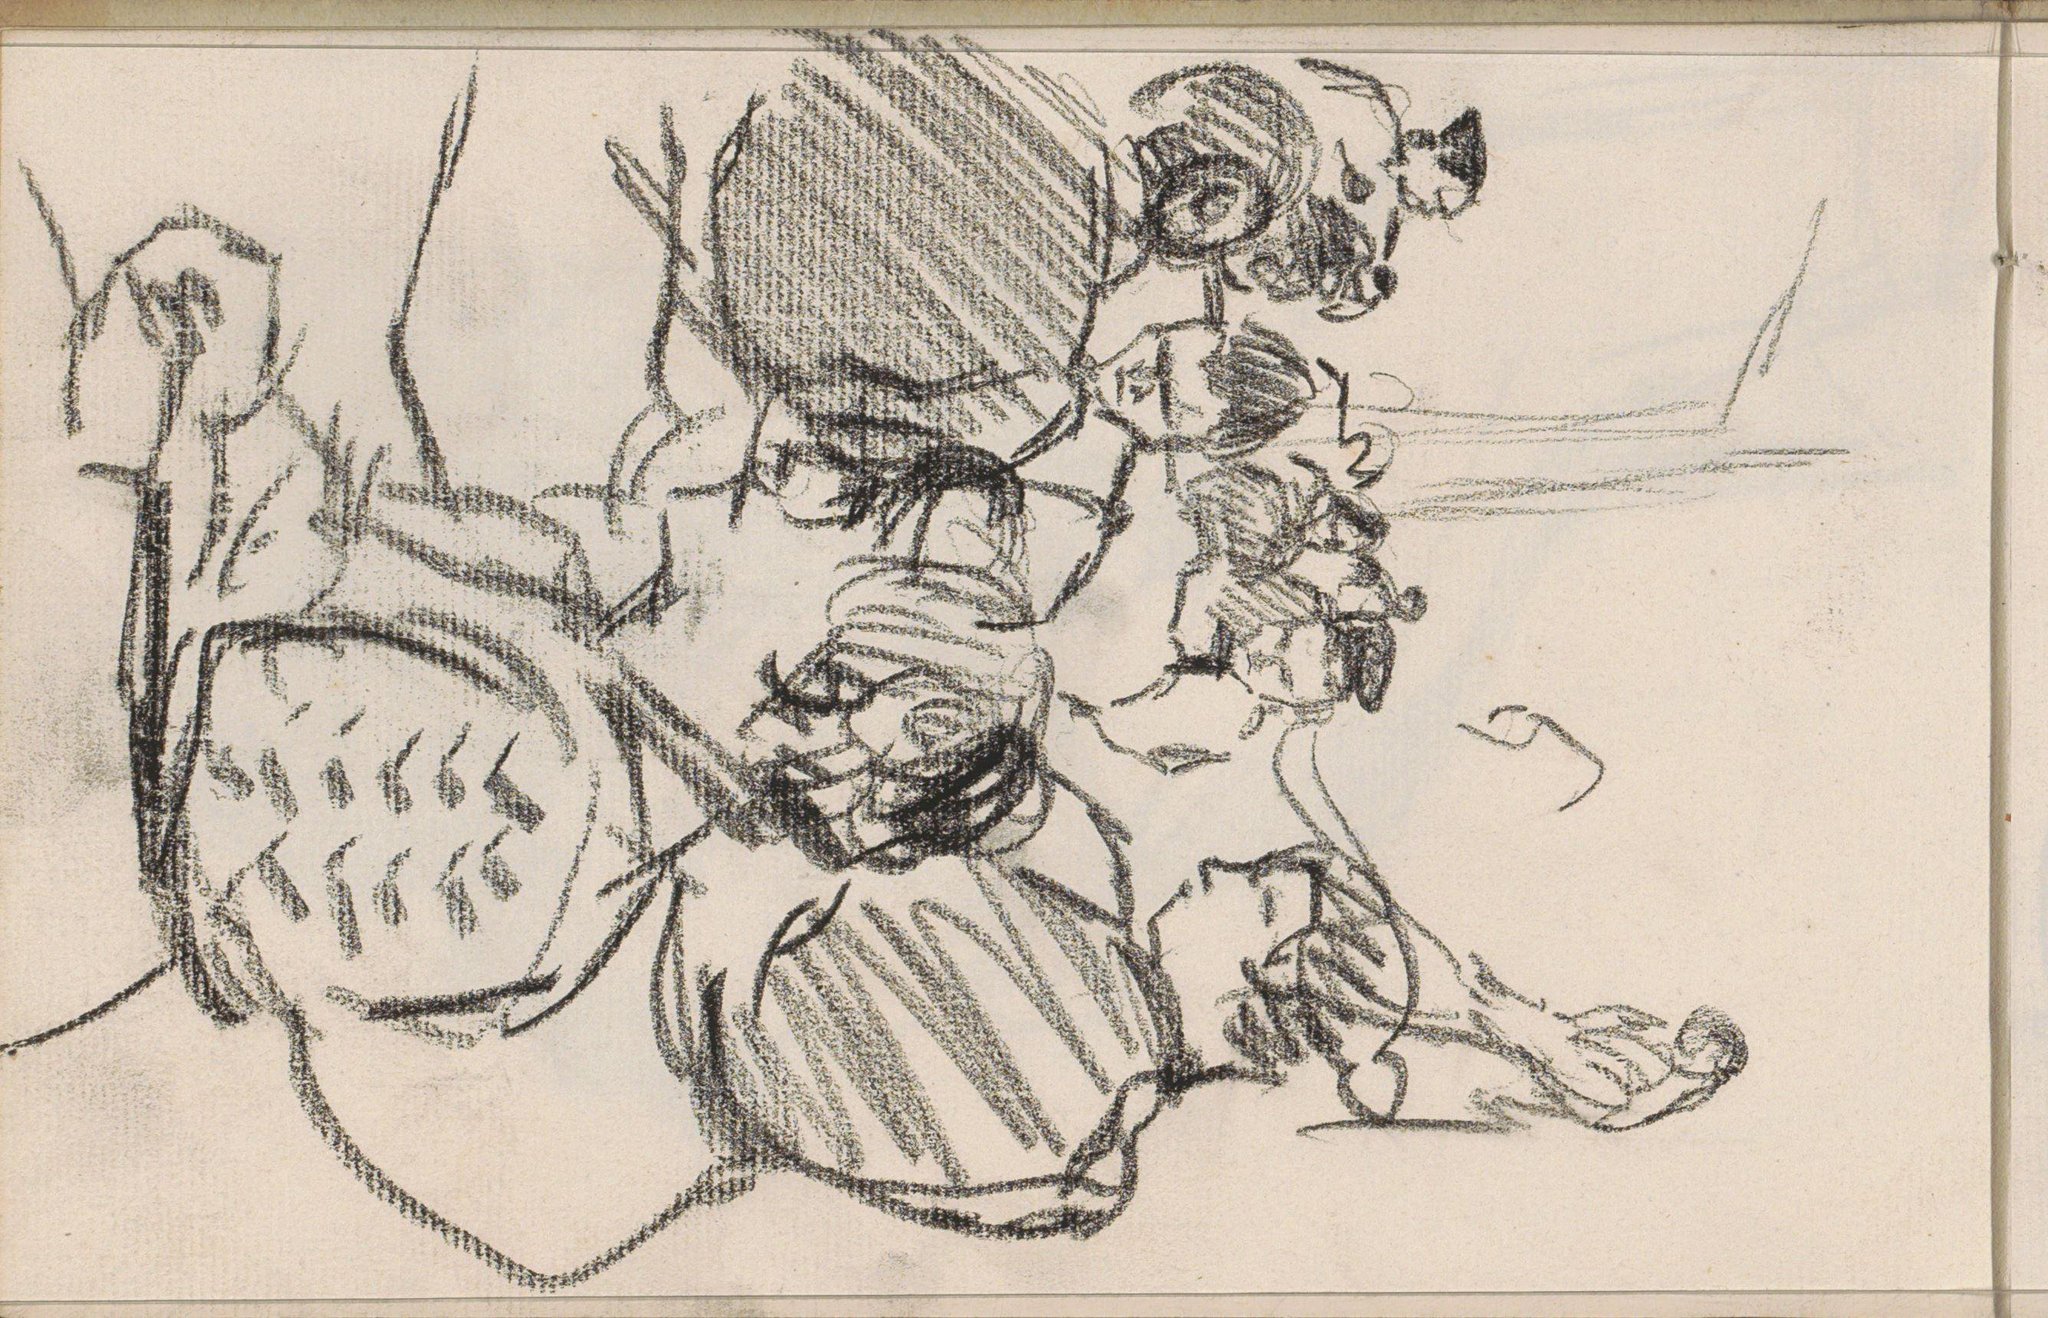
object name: sketchbook leaf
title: Interieur met zittende vrouwen, mogelijk koffiepiksters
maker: isaac israels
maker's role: draughtsman, painter, print maker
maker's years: 1865-1934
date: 1886-1903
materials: chalk, paper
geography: amsterdam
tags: adult woman (+ sitting)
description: Pagina 17 uit schetsboek XXXIII met 47 pagina's.